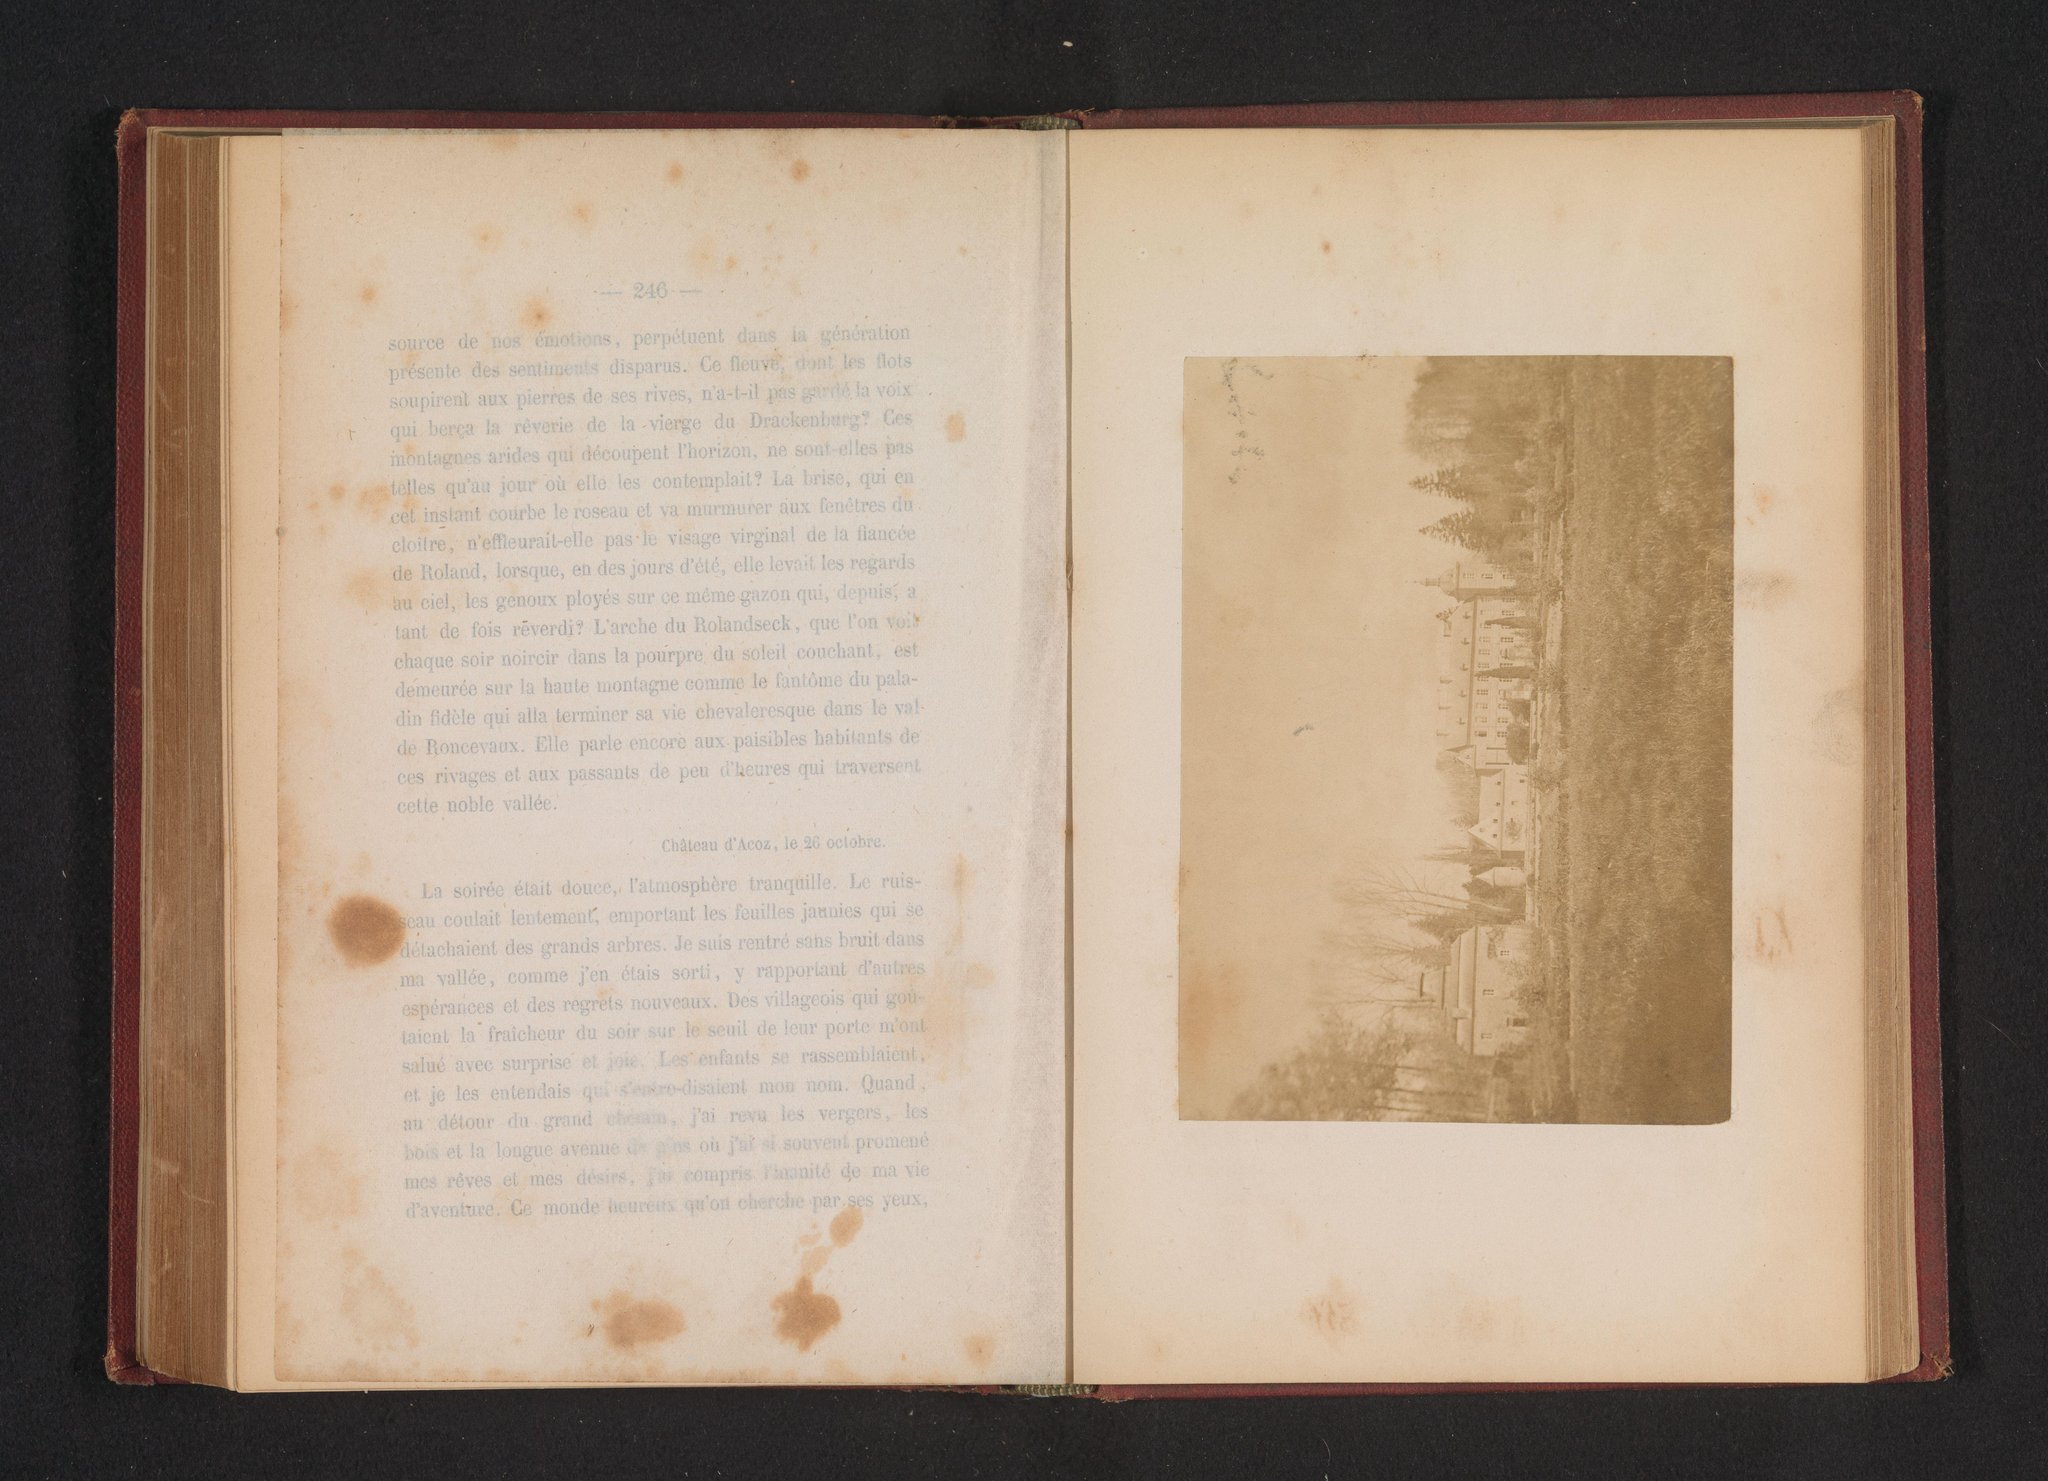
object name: page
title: Gezicht op Château d'Acoz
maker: Anonymous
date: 1864-1869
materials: photographic support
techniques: albumen print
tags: rural housing, e.g. country-house, villa, cottage, belgium